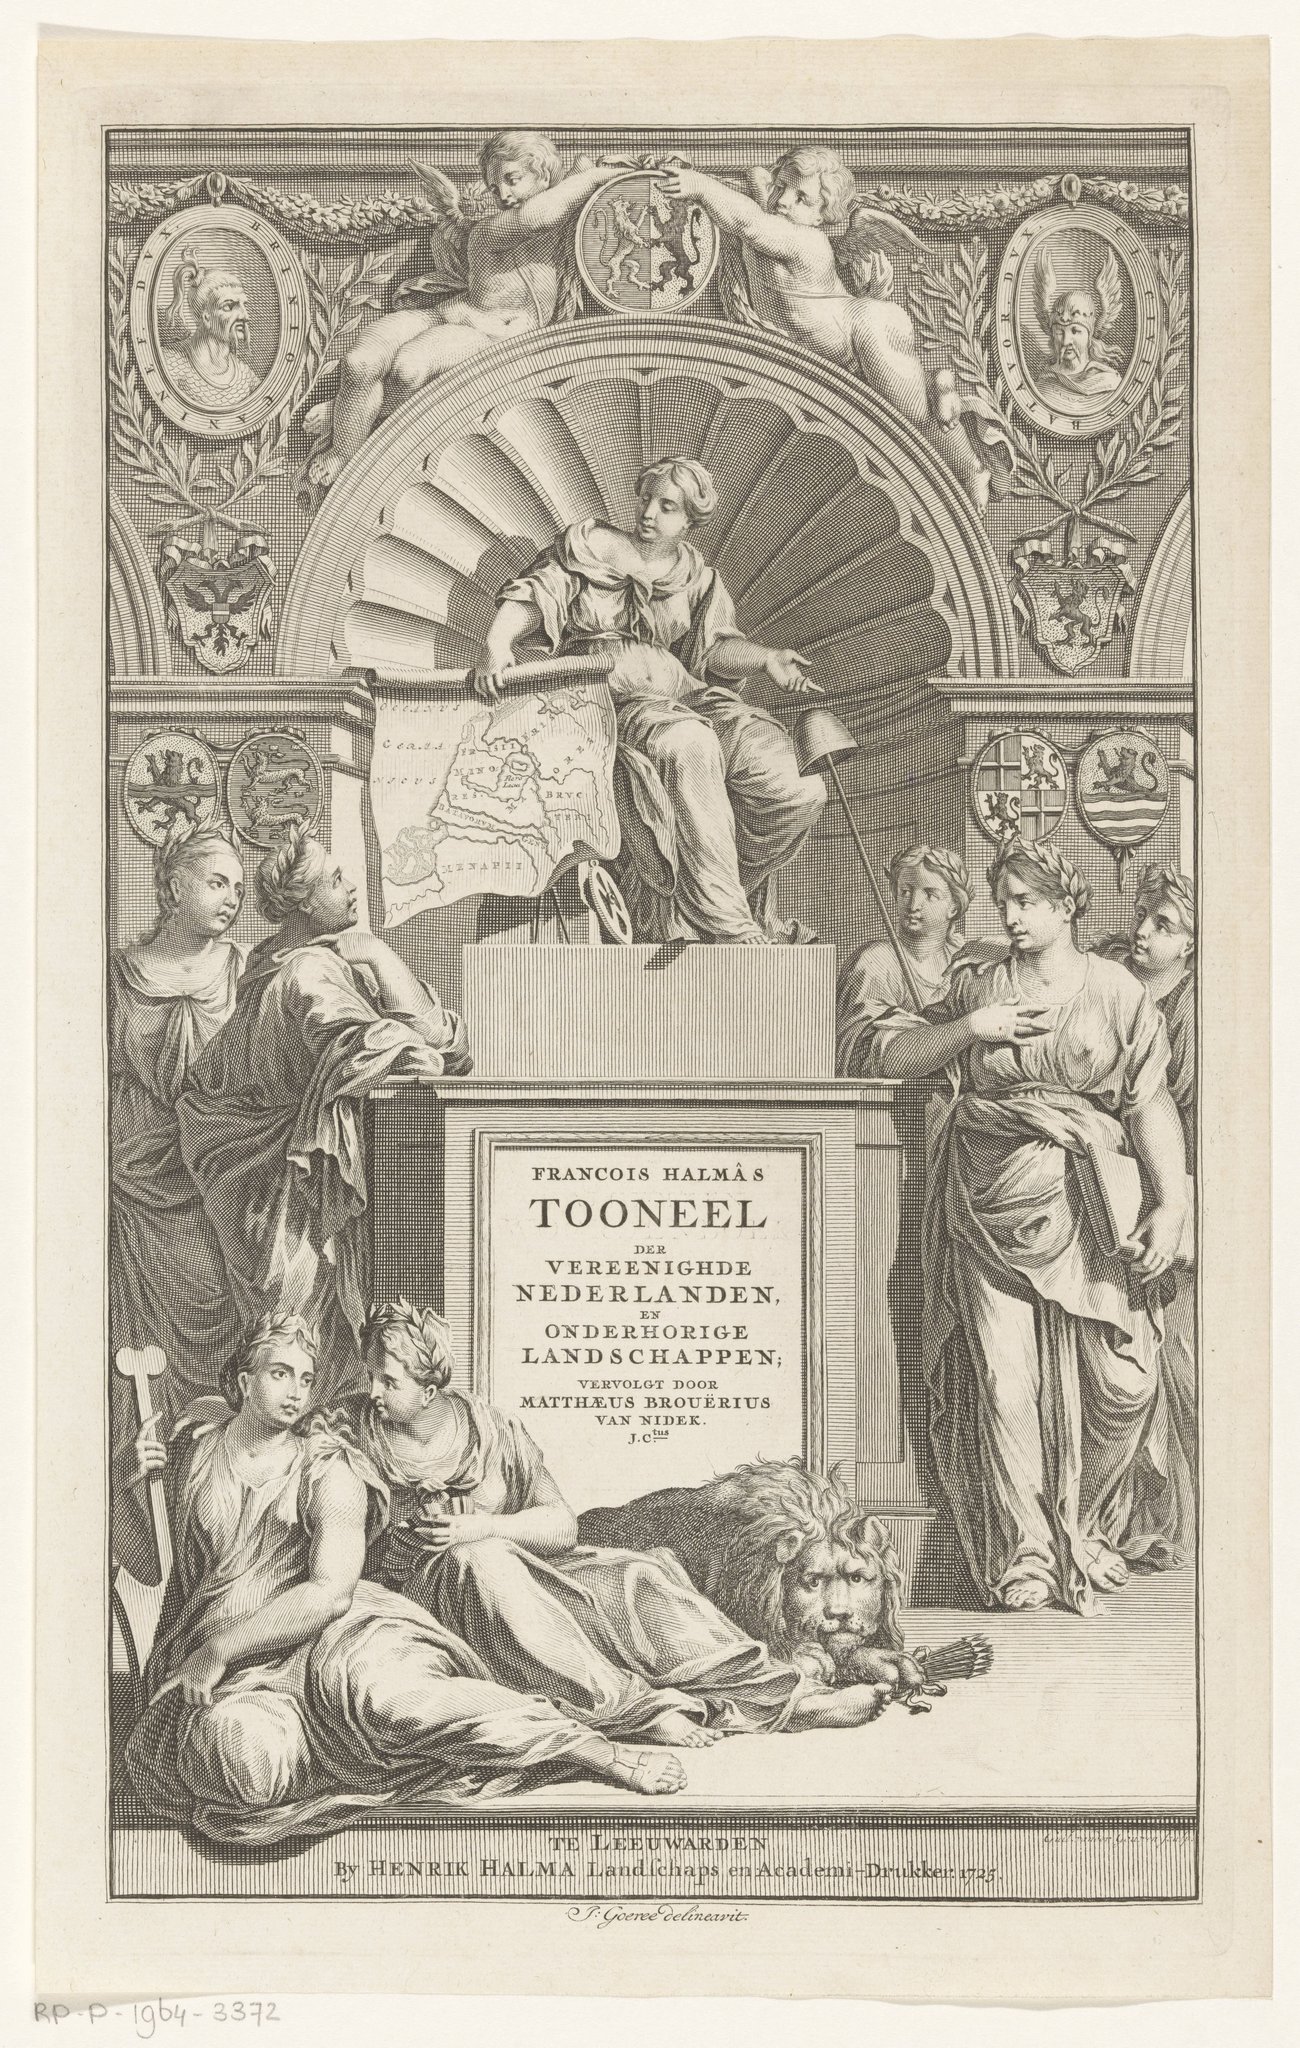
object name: print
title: Titelpagina voor: François Halma en Matthaeus Brouërius van Nidek, Tooneel der Vereenighde Nederlanden en onderhorige landschappen, 1725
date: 1725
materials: paper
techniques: engraving, etching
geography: leeuwarden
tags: brinio, coat of arms (as symbol of the state, etc.), personifications of countries, nations, states, districts, etc., beasts of prey, predatory animals: lion (+ animals used symbolically), netherlands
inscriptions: collector's mark: Lugt 2228, collector's mark: Lugt 2780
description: De Hollandse Maagd zit op een verhoogde troon, omringd door de personificaties van de zeven provincies. Ze houdt een kaart van de Nederlanden in de hand. Op de troon de titel van het boekwerk. Onder de troon de Nederlandse leeuw, met in zijn klauwen een bundel pijlen. Aan de bovenzijde portretmedaillons van Brinio, veldheer van de Cananefaten en Julius Civilis, leider in de Batavenopstand.